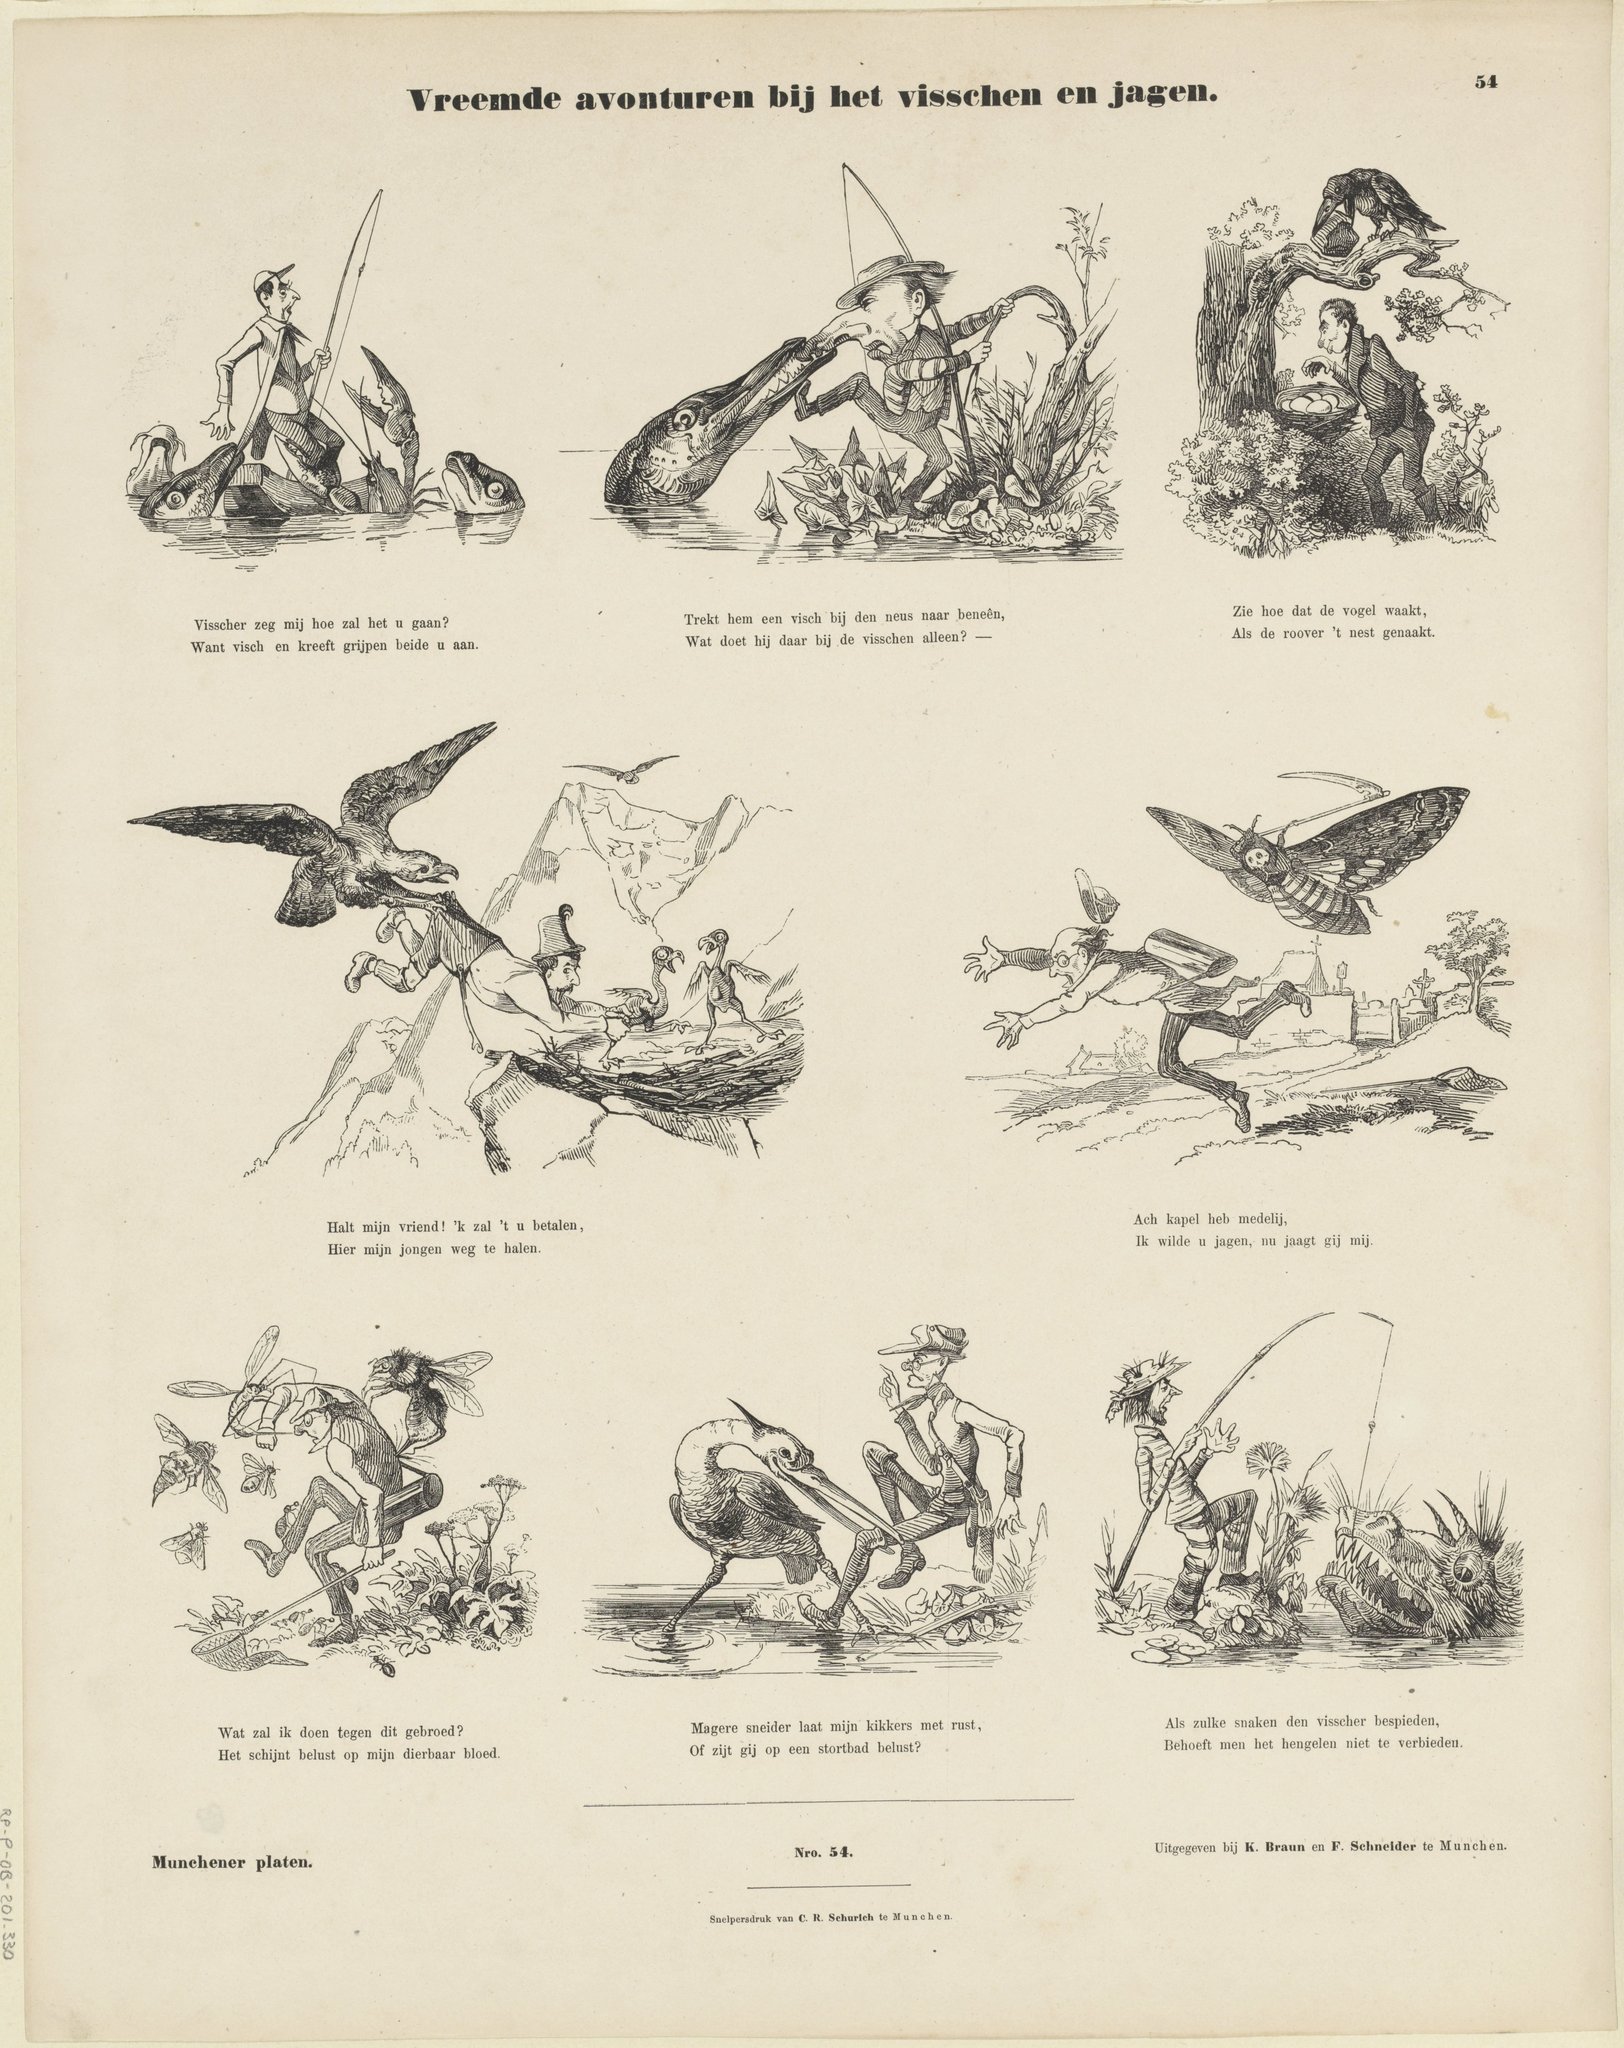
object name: print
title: Vreemde avonturen bij het visschen en jagen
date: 1843-1920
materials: paper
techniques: letterpress printing, engraving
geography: munich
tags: commercial fishery, animals, hunter, fisherman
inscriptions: collector's mark: Lugt 2760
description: Blad met 8 karikaturale voorstellingen van mannen die vissen en jagen. Onder elke afbeelding een onderschrift. Genummerd midden onder: Nro. 54. Genummerd rechtsboven: 54.